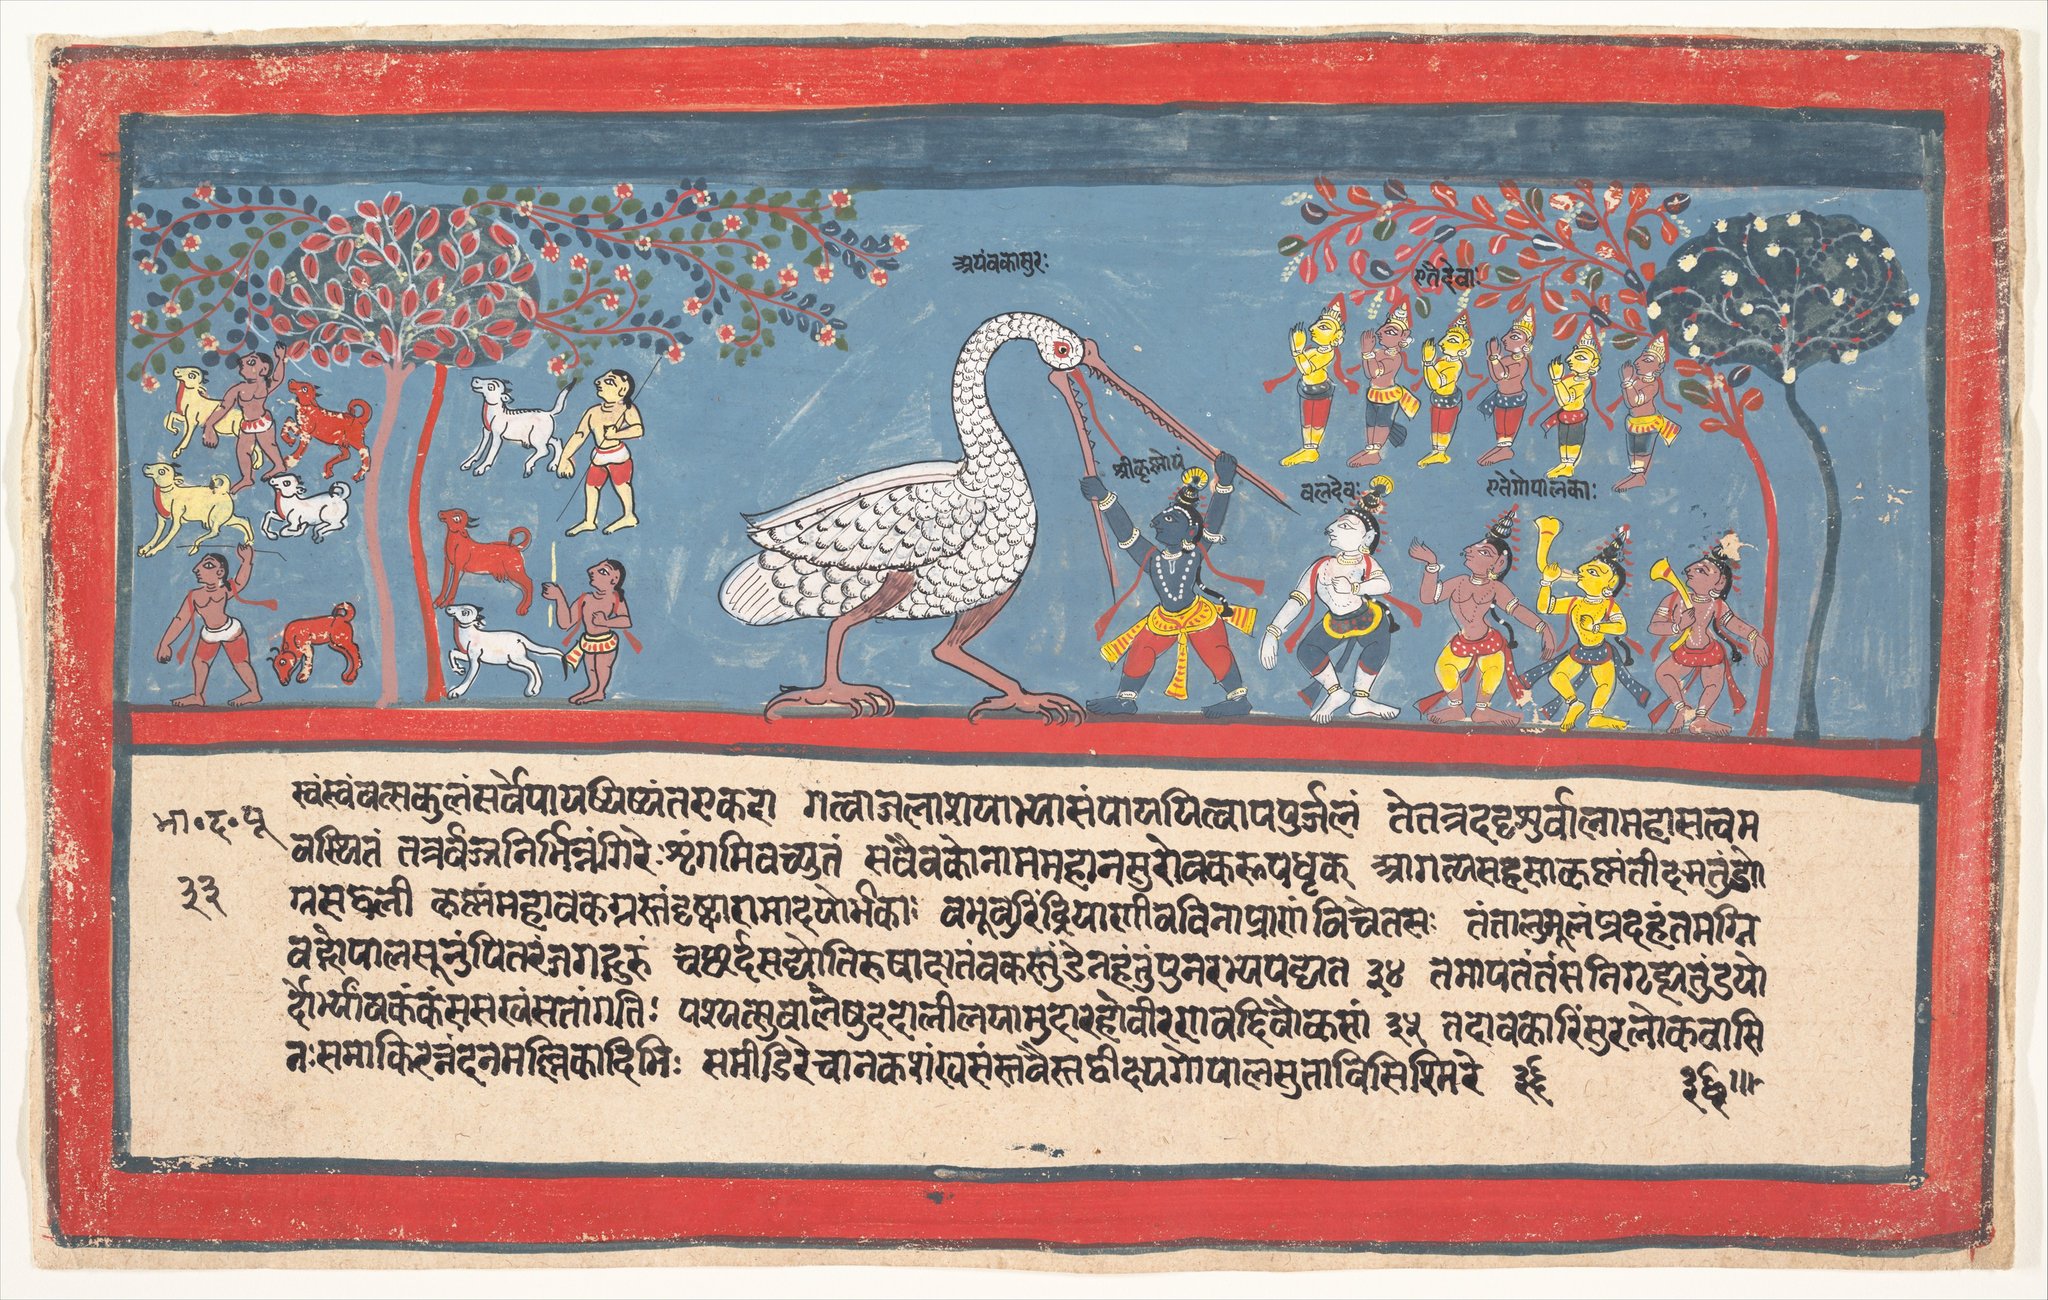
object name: folio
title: Krishna Slays Bakasura, the Crane Demon: Page from a Dispersed Bhagavata Purana (Ancient Stories of Lord Vishnu))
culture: indian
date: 1800-1825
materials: ink, paper, watercolor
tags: cranes,demons,krishna